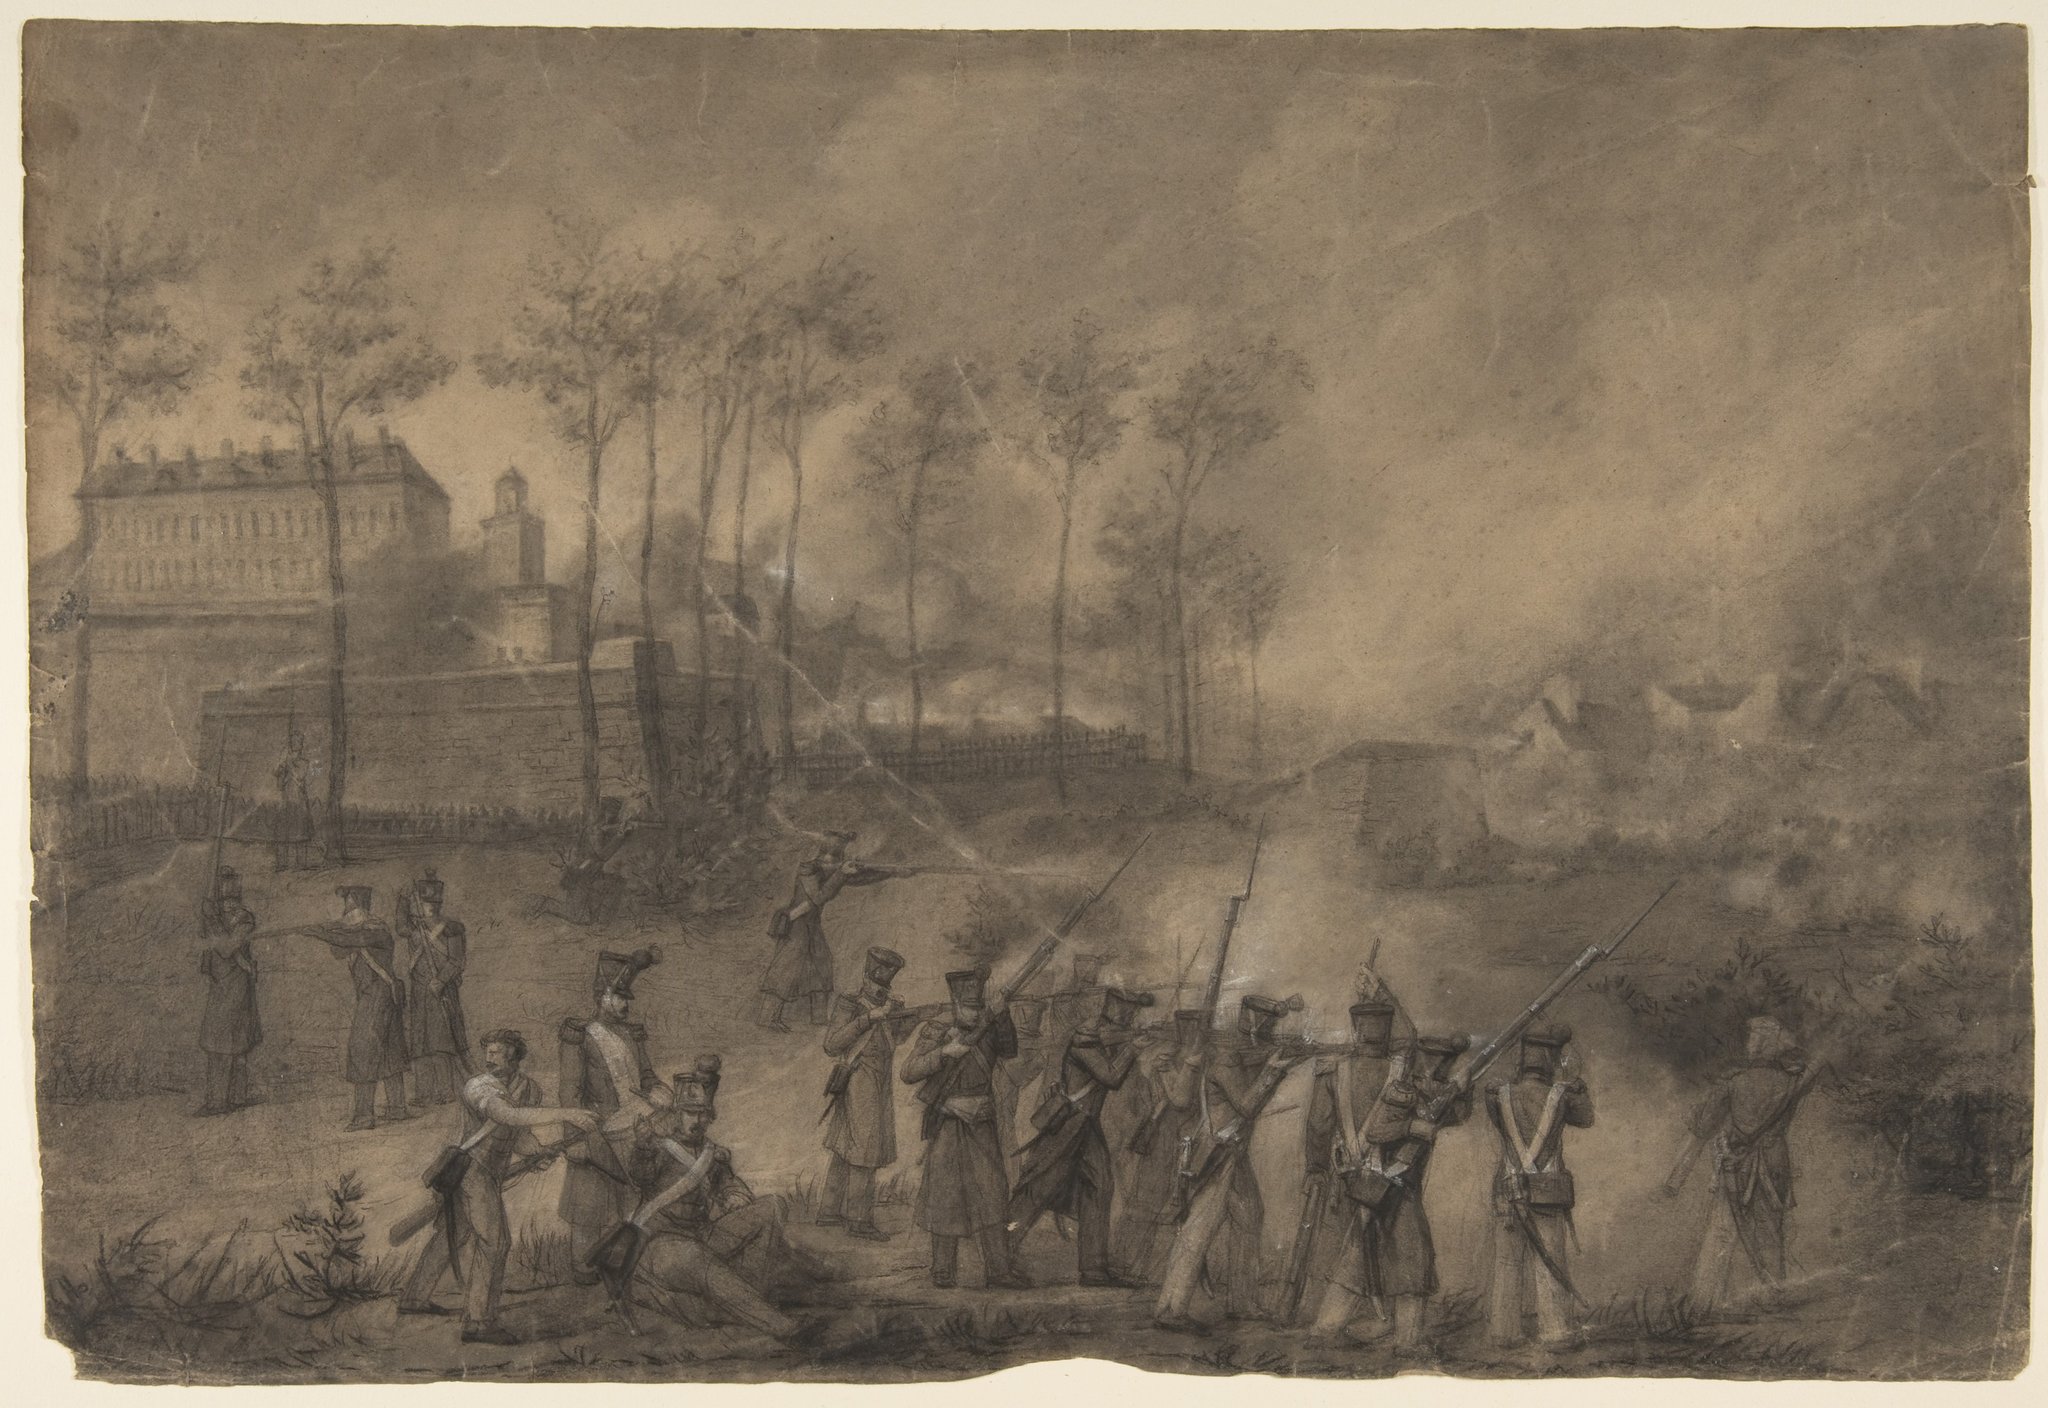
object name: drawing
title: Battle Scene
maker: anonymous, french, 19th century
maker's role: artist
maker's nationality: french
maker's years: 1800-1900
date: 1801-1900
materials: chalk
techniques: heightening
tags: battles,soldiers,firearms